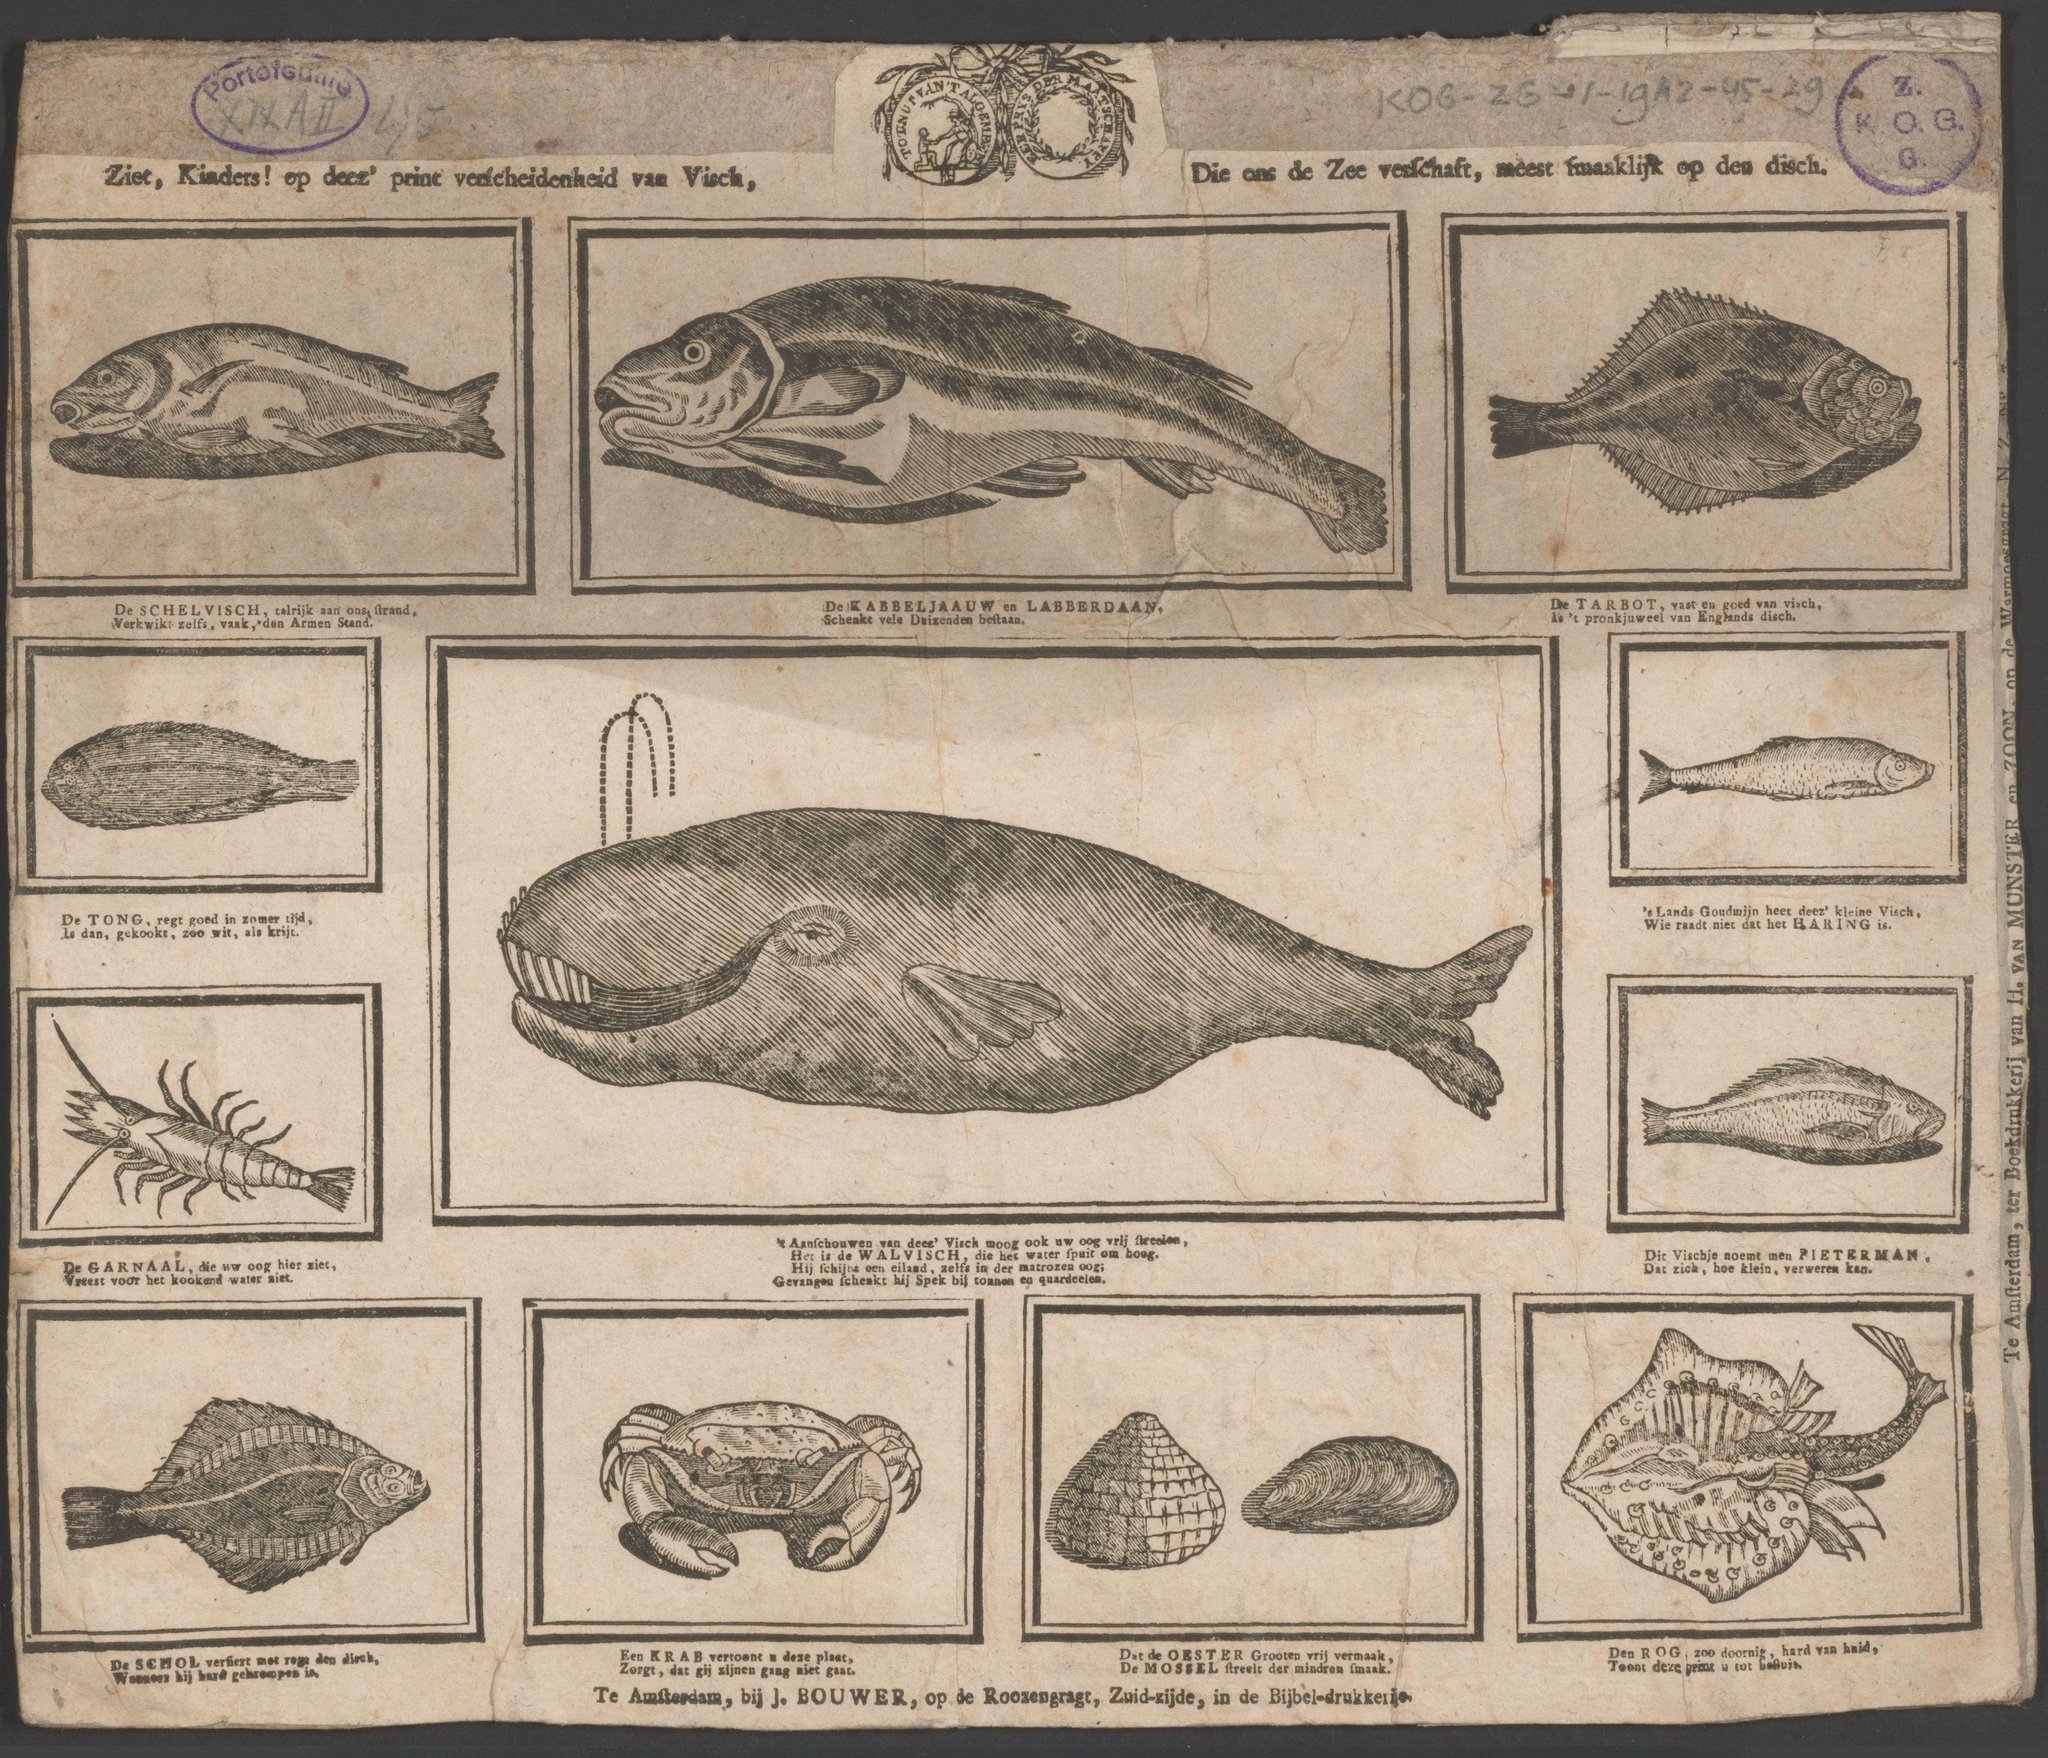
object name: print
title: Potvis, andere vissen en schaal- en schelpdieren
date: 1805-1808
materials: paper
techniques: letterpress printing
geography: amsterdam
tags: fishes, molluscs: oyster, crustaceans: crab, crustaceans: lobster, molluscs: mussel, swimming mammals: whale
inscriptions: stamp, collector's mark: Lugt 1641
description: Blad met twaalf voorstellingen van vissen, een walvis en schaaldieren. Midden boven het zegel van de Maatschappij tot Nut van 't Algemeen. Onder elke afbeelding een tweeregelig vers met de naam van het dier. Onderwerpsrubrieken binnen de Atlas Zeden en Gewoonten: Zeden en gewoonten in engeren zin, Des menschen begin, midden en einde, Kinderprenten opgeplakt op karton.